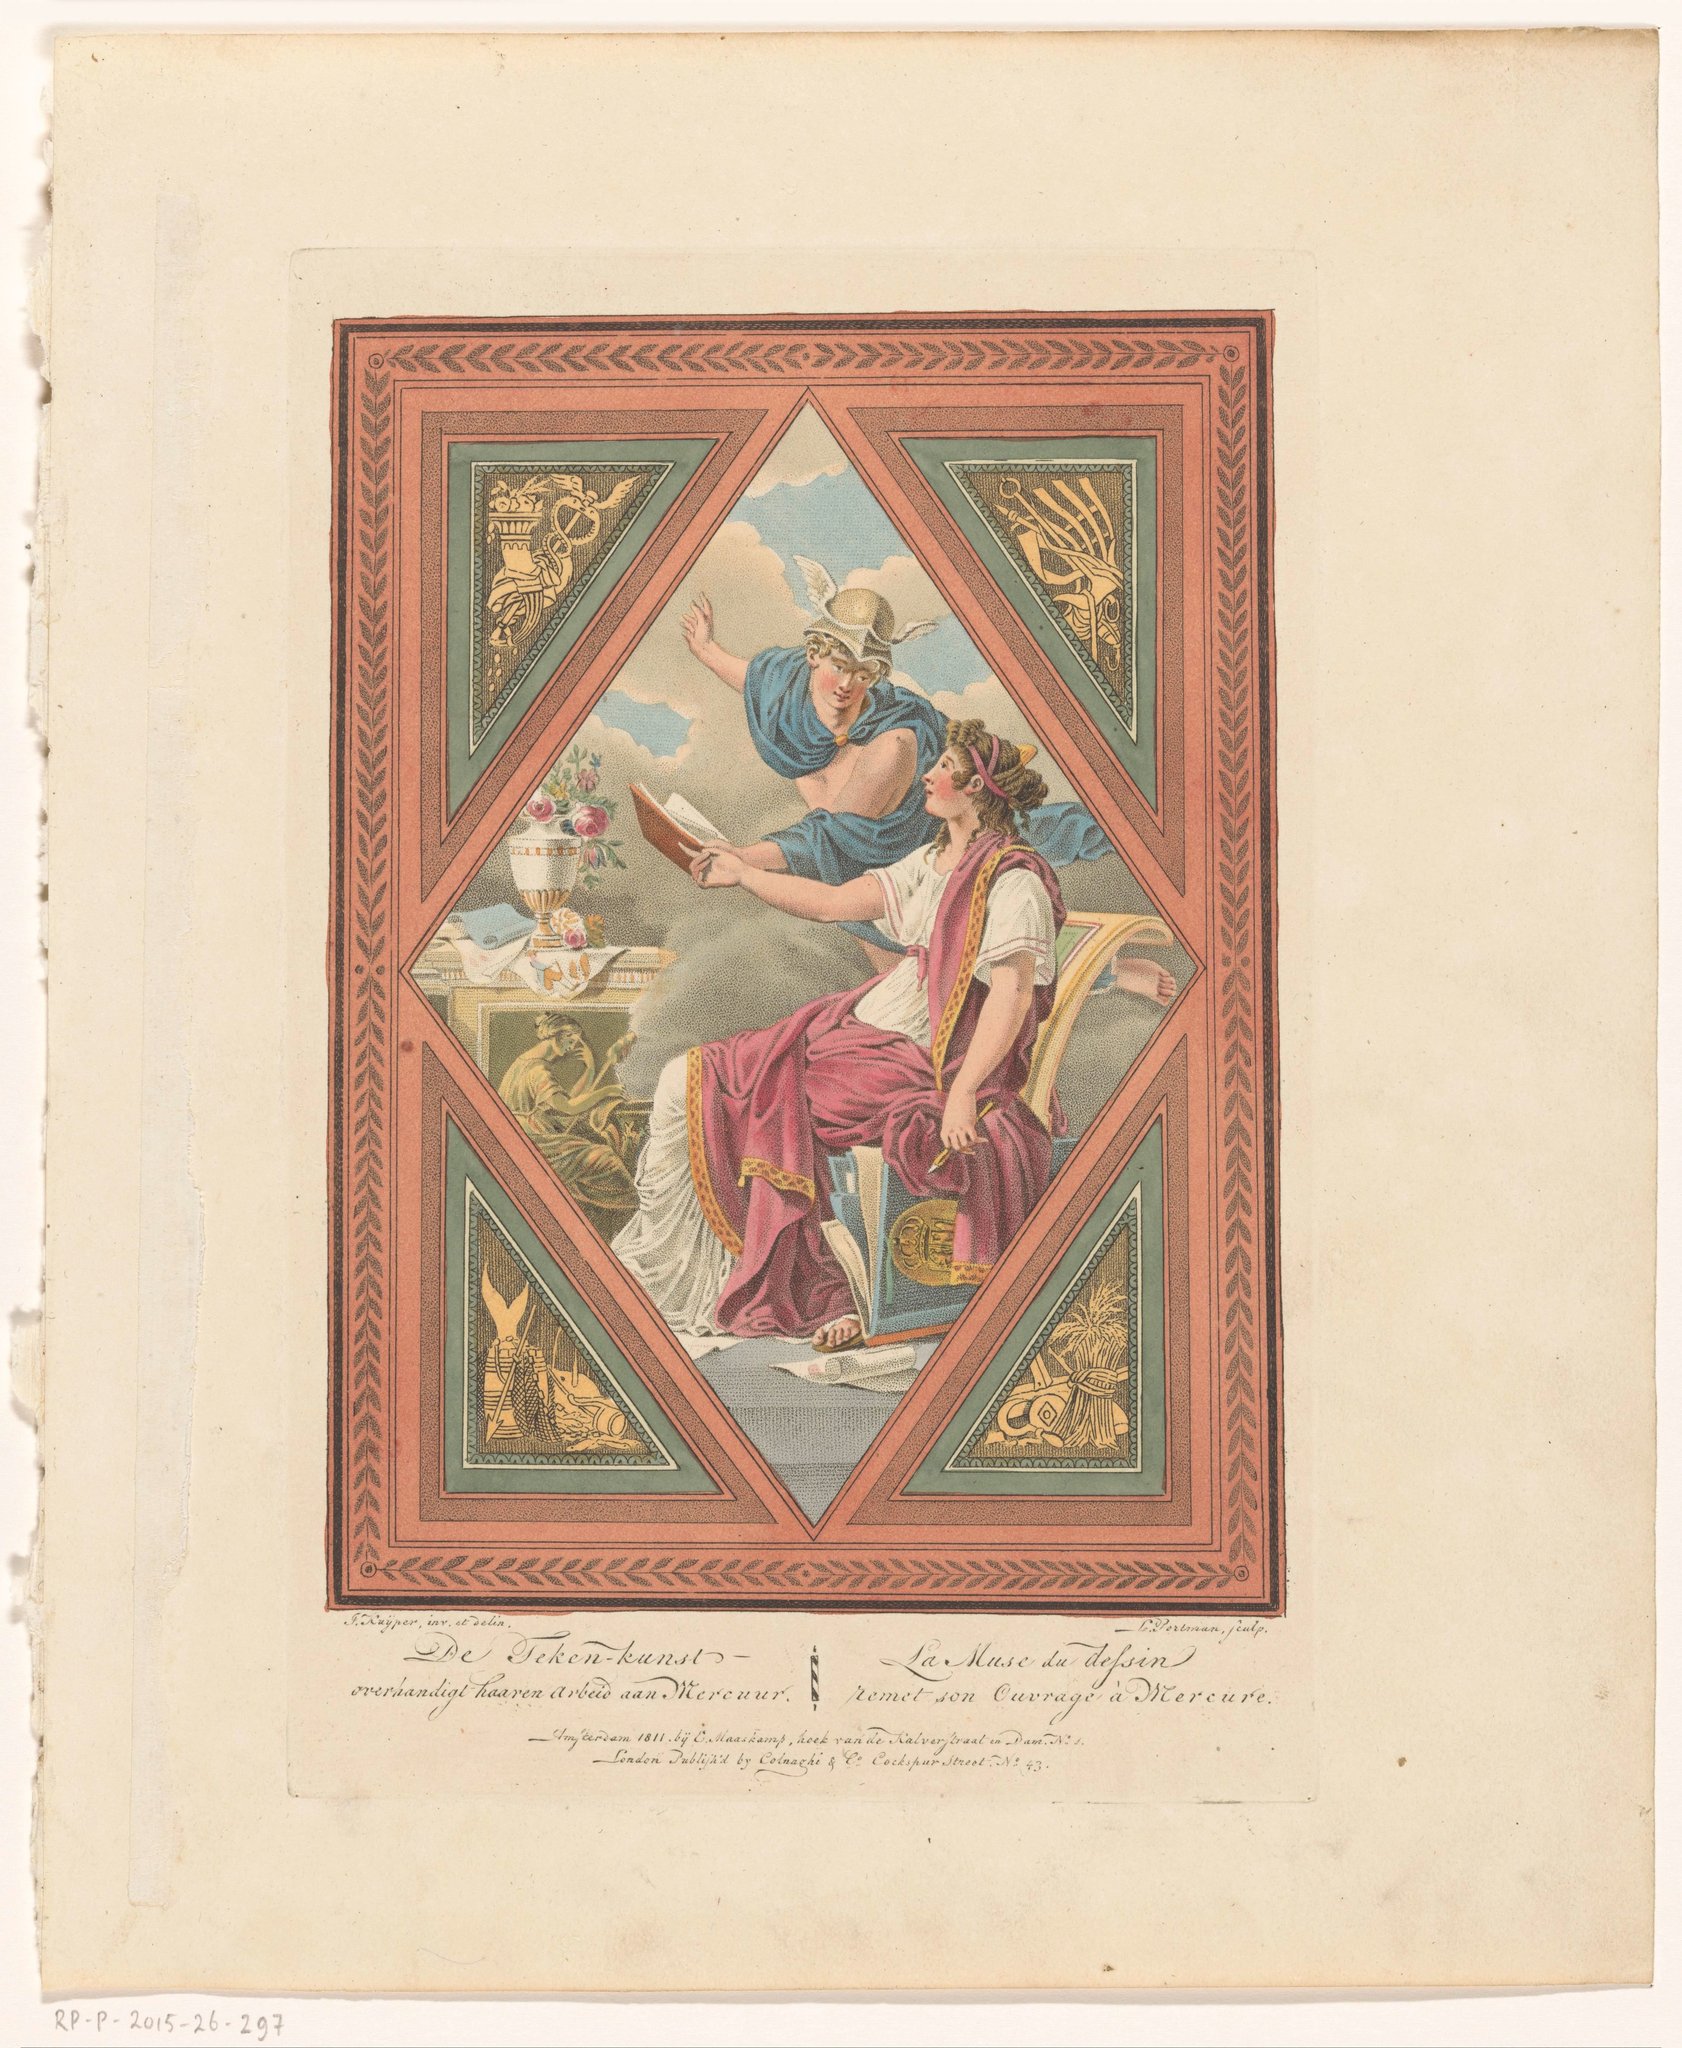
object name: book illustration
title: Tekenkunst toont haar werk aan Mercurius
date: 1805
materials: paper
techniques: etching, hand coloring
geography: london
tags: symbolic representations, allegories and emblems ~ drawing, specific aspects, allegorical aspects of mercury; mercury as patron - veneration, honoured by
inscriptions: collector's mark: Lugt 2228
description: Gebruikt als illustratie in: Evert Maaskamp, Afbeeldingen van de kleedingen, zeden en gewoonten in de noordelijke provincien van het Koningrijk der Nederlanden, met den aanvang der negentiende eeuw = Tableaux des habillemens, mœurs et coutumes dans les provinces septentrionales du Royaume des Pays-Bas, au commencement du dix-neuvième siècle. Amsterdam: Evert Maaskamp, 1811 [heruitgave van de oorspronkelijke platen eerst verschenen in 1803-1807].